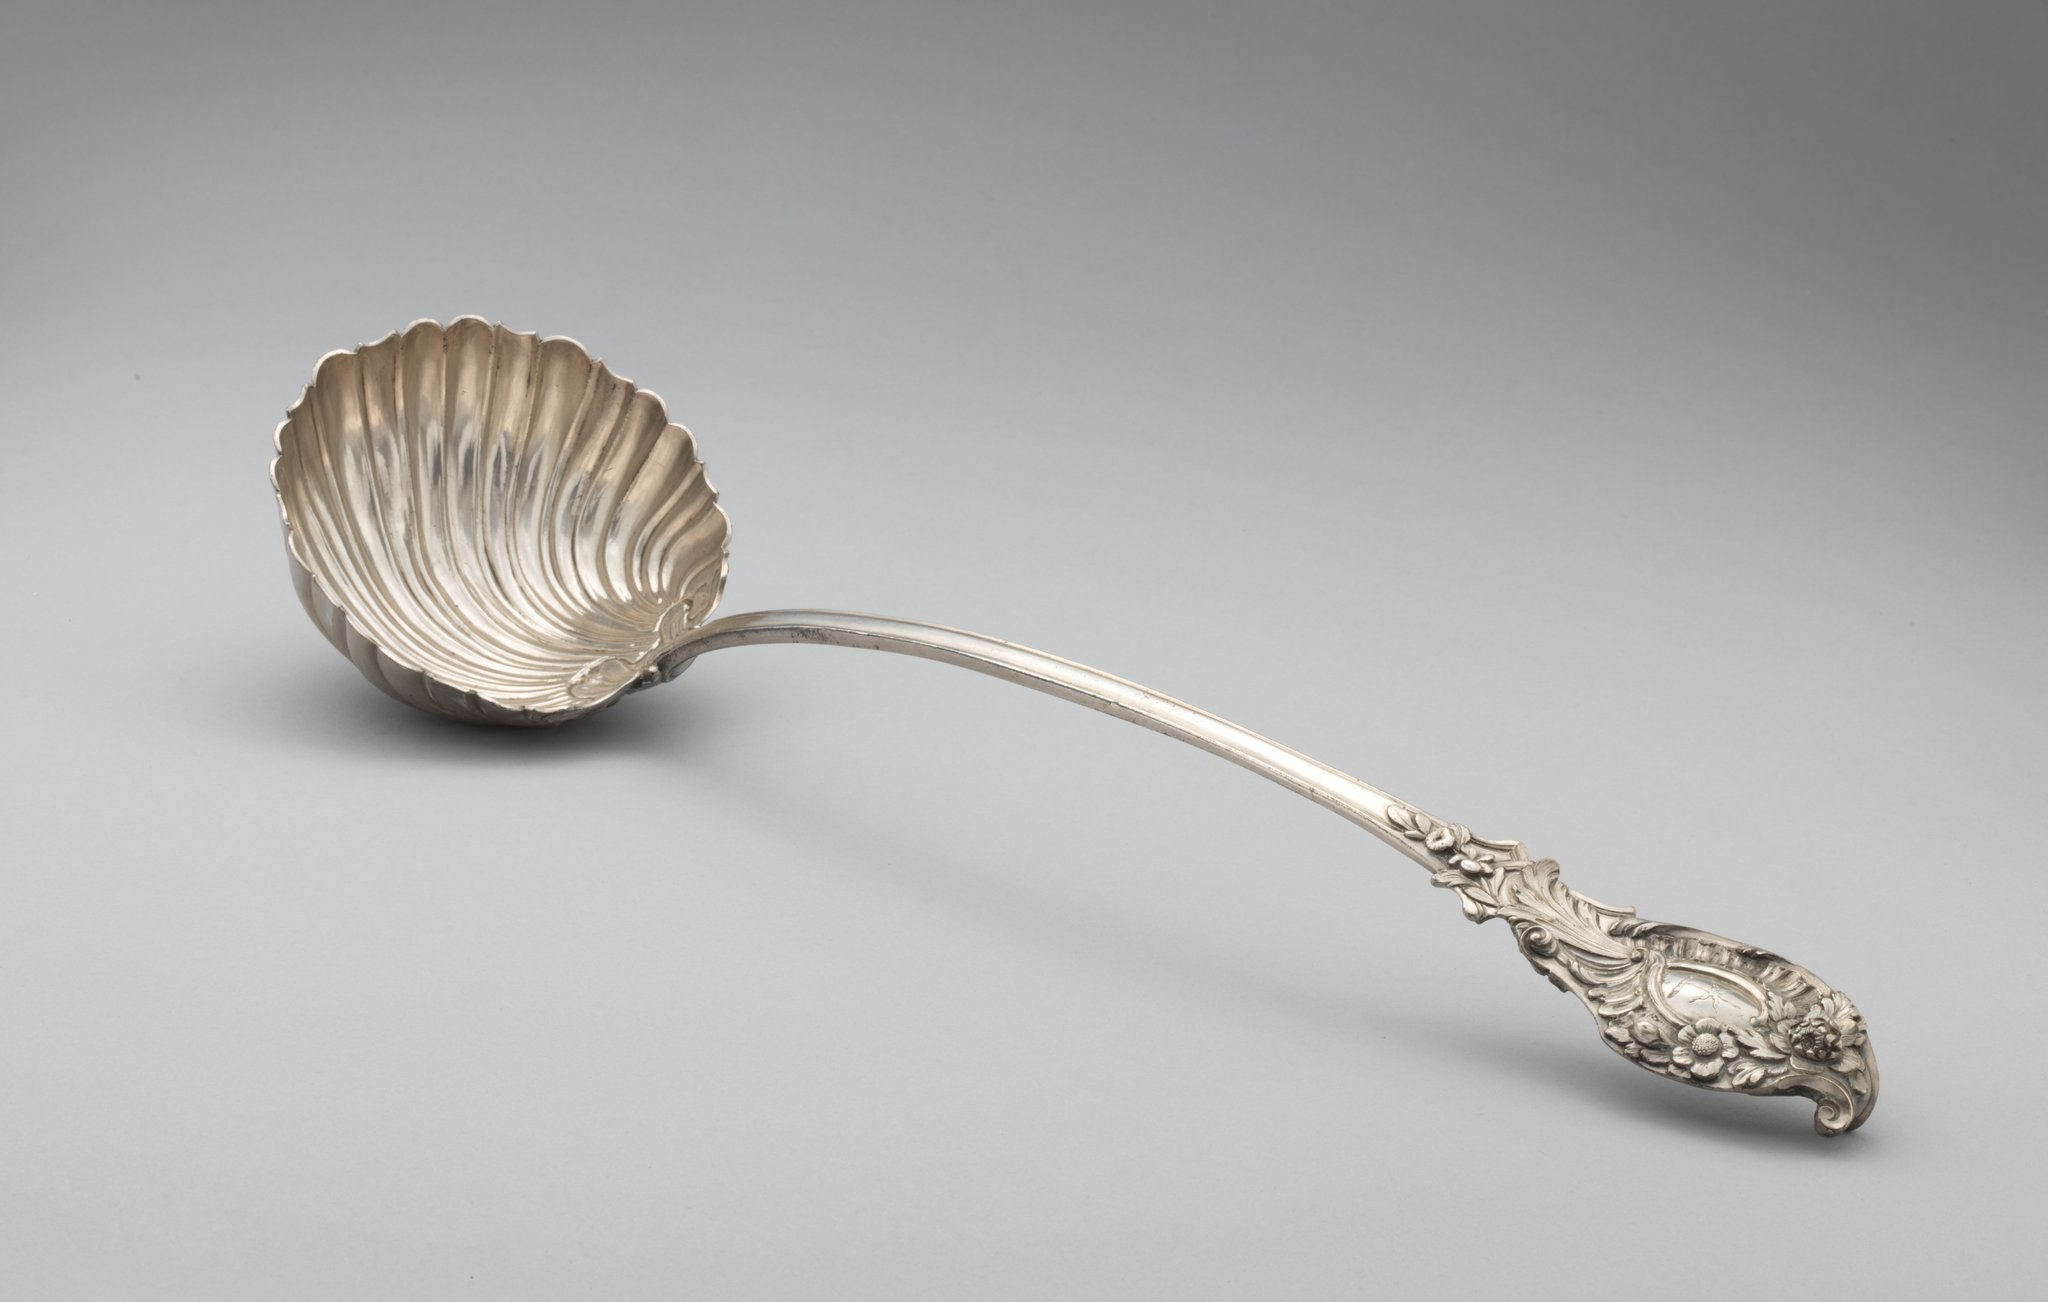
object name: ladle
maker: john wirgman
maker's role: maker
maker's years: 1745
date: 1758-1759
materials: silver